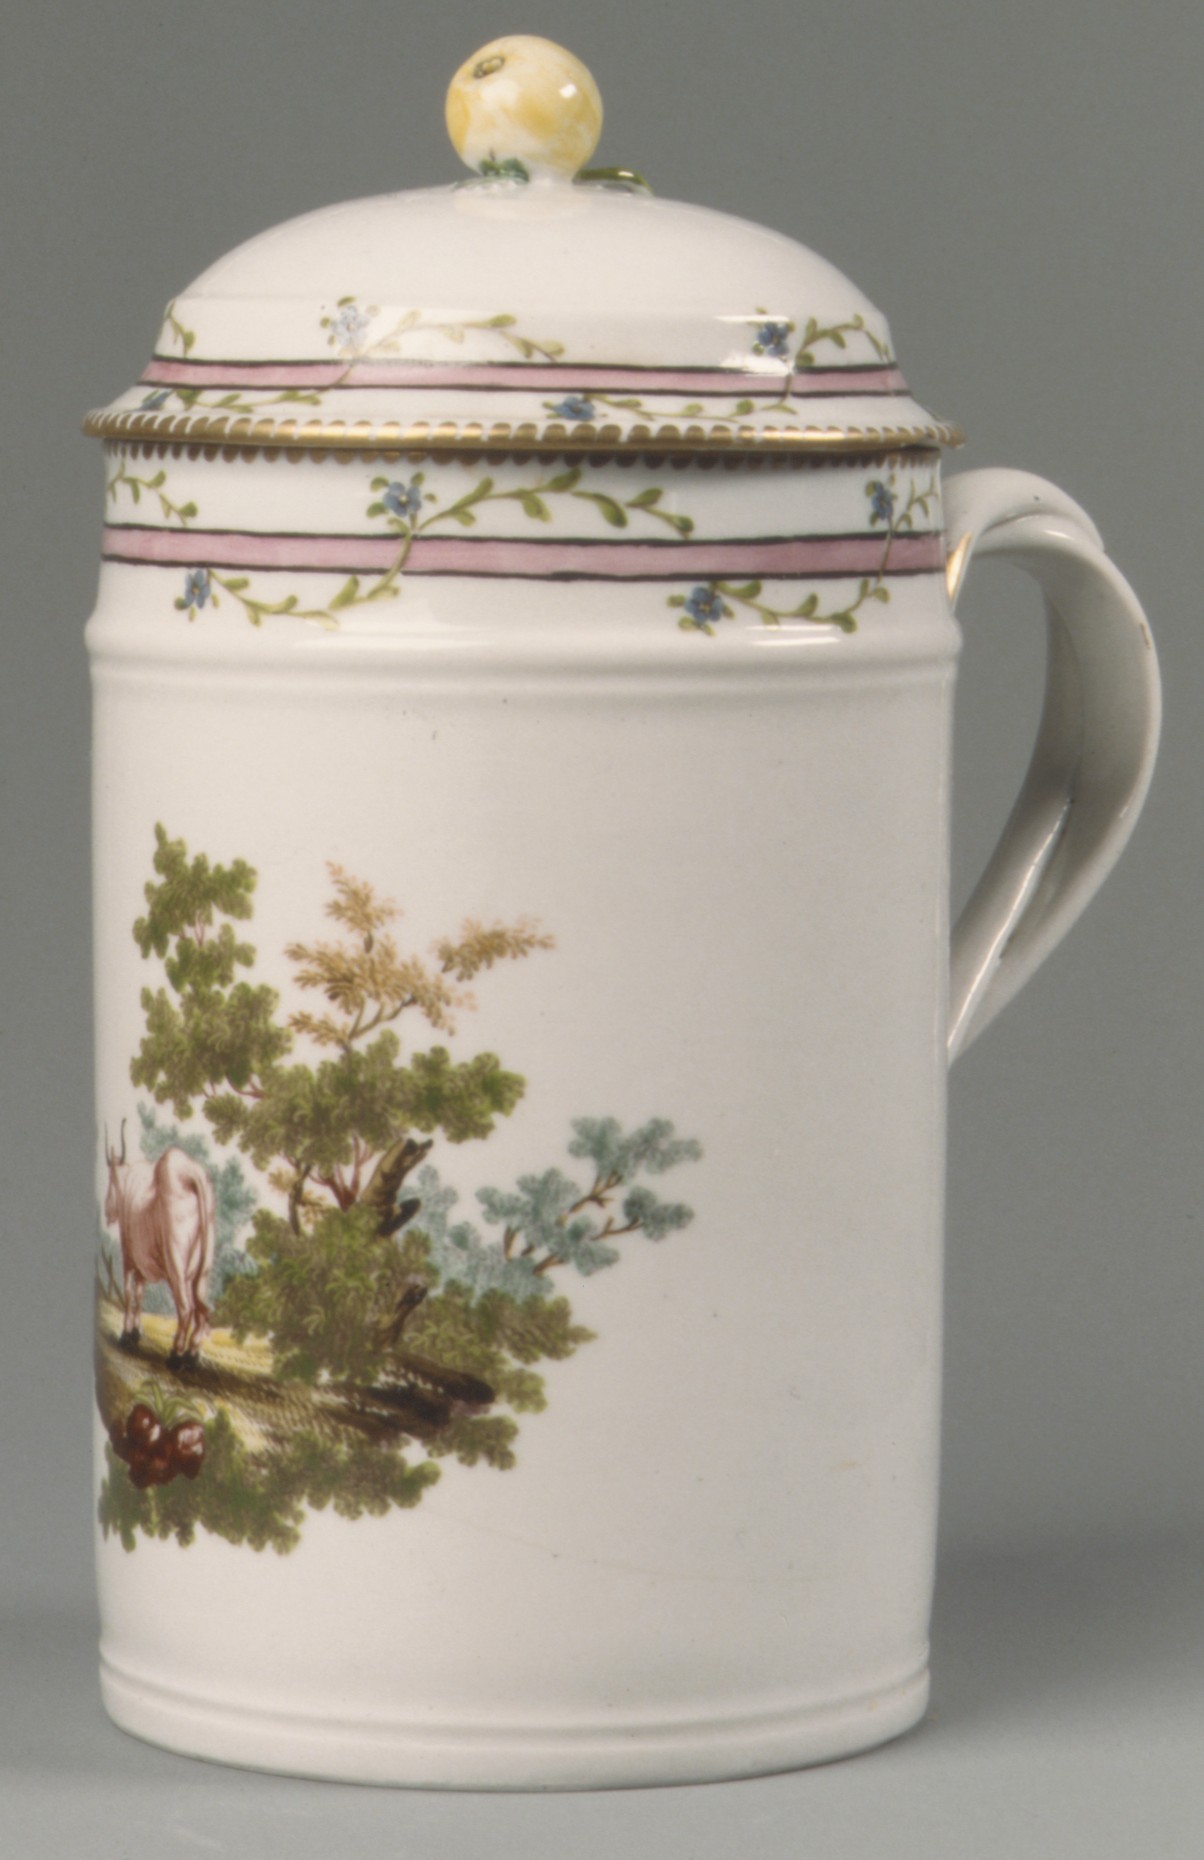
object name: tankard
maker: imperial porcelain manufactory, st. petersburg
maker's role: manufactory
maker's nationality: russian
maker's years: 1744-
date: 1780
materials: hard paste porcelain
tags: cows,trees